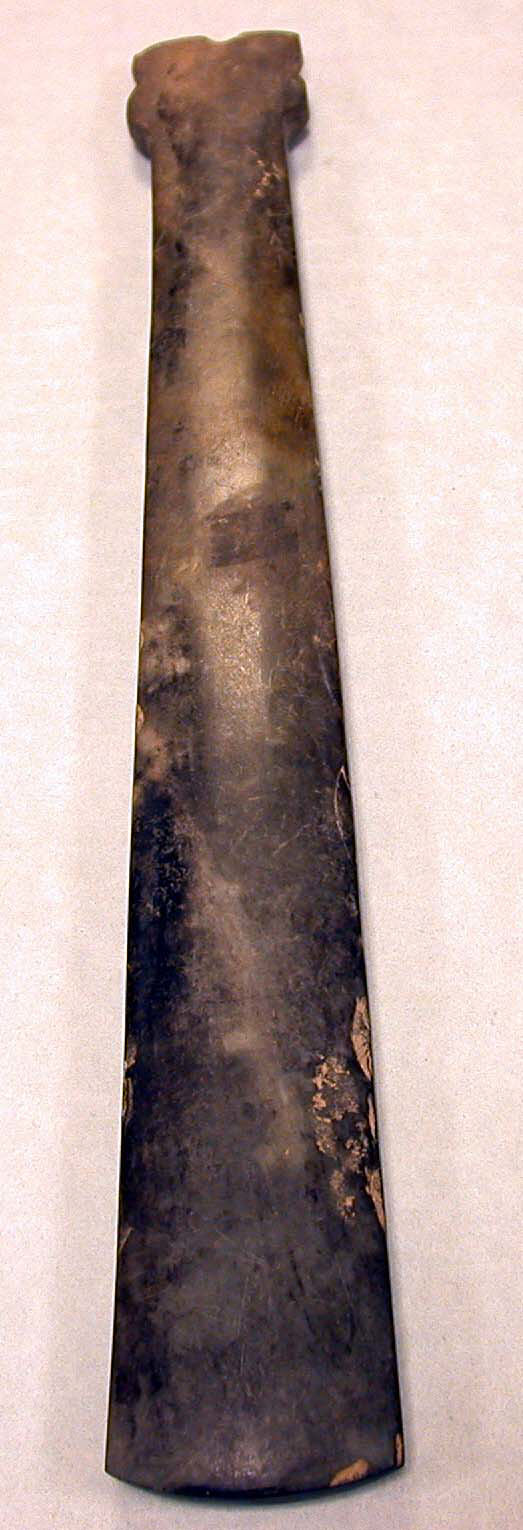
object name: scepter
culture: tairona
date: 1501-1600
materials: stone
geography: colombia